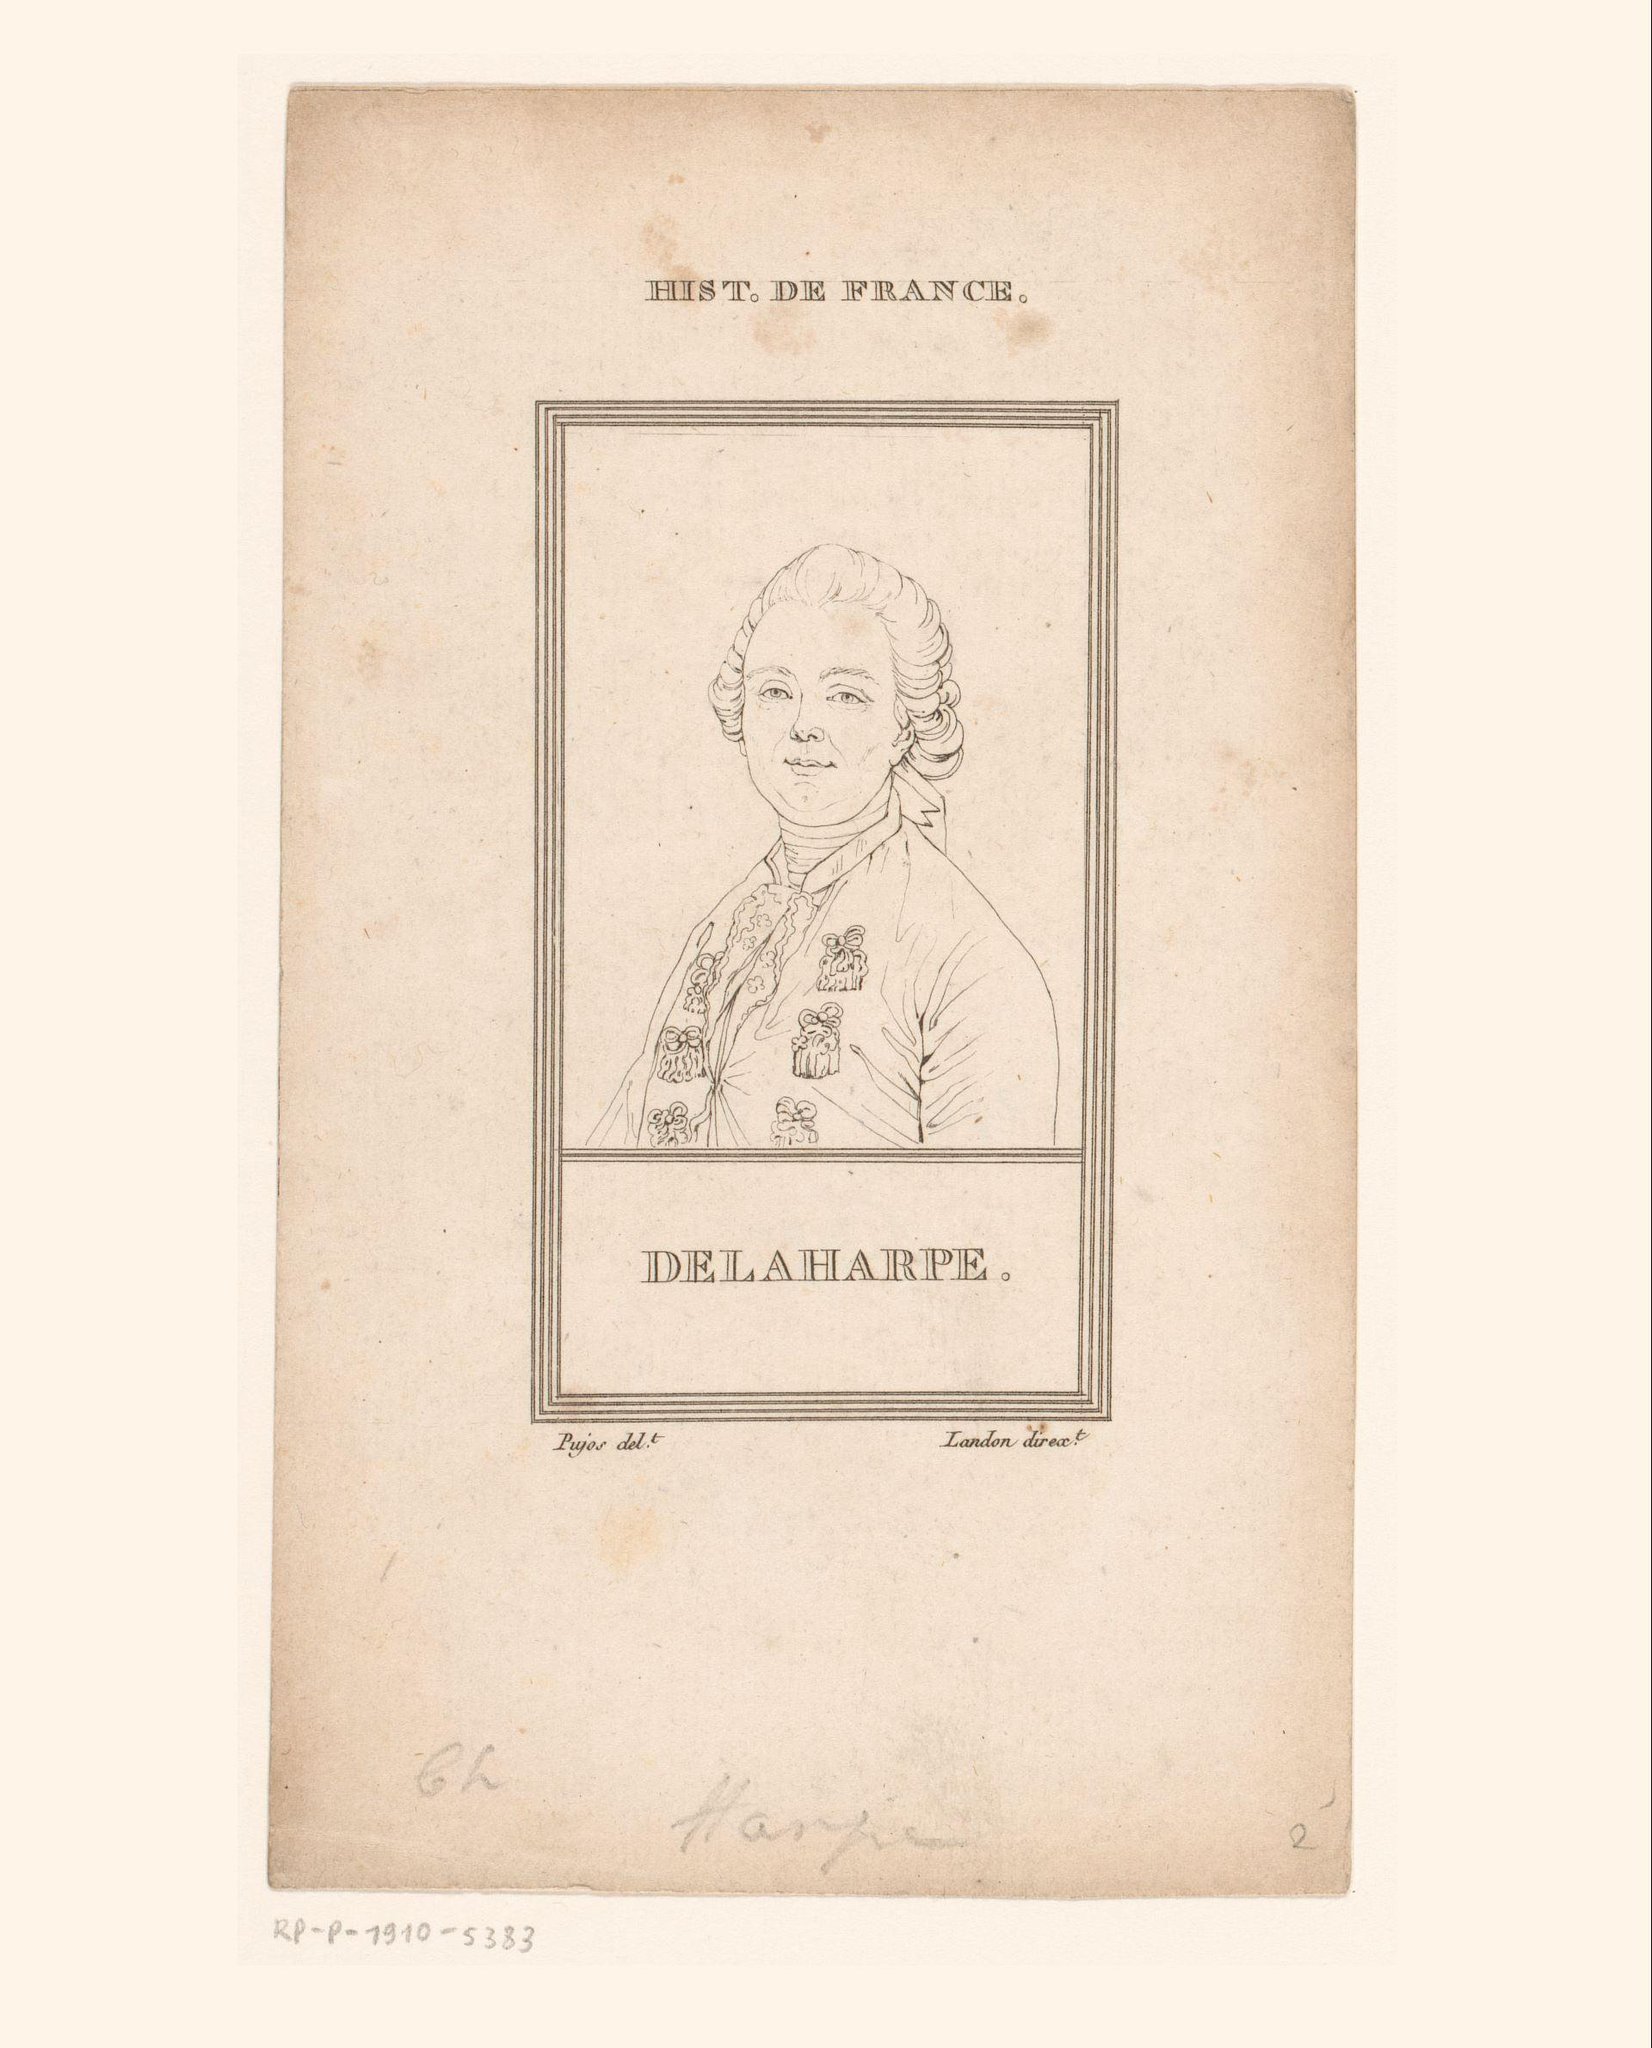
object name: book illustration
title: Portret van Jean-François de La Harpe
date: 1805-1811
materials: paper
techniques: etching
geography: france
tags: paris, historical persons, portrait of a writer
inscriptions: collector's mark: Lugt 2228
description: Prent uit: Landon, Charles Paul. Galerie historique des hommes les plus celebres de tous les nations. (...). Parijs: Musée et l'école des beaux-arts, 1805-1811.